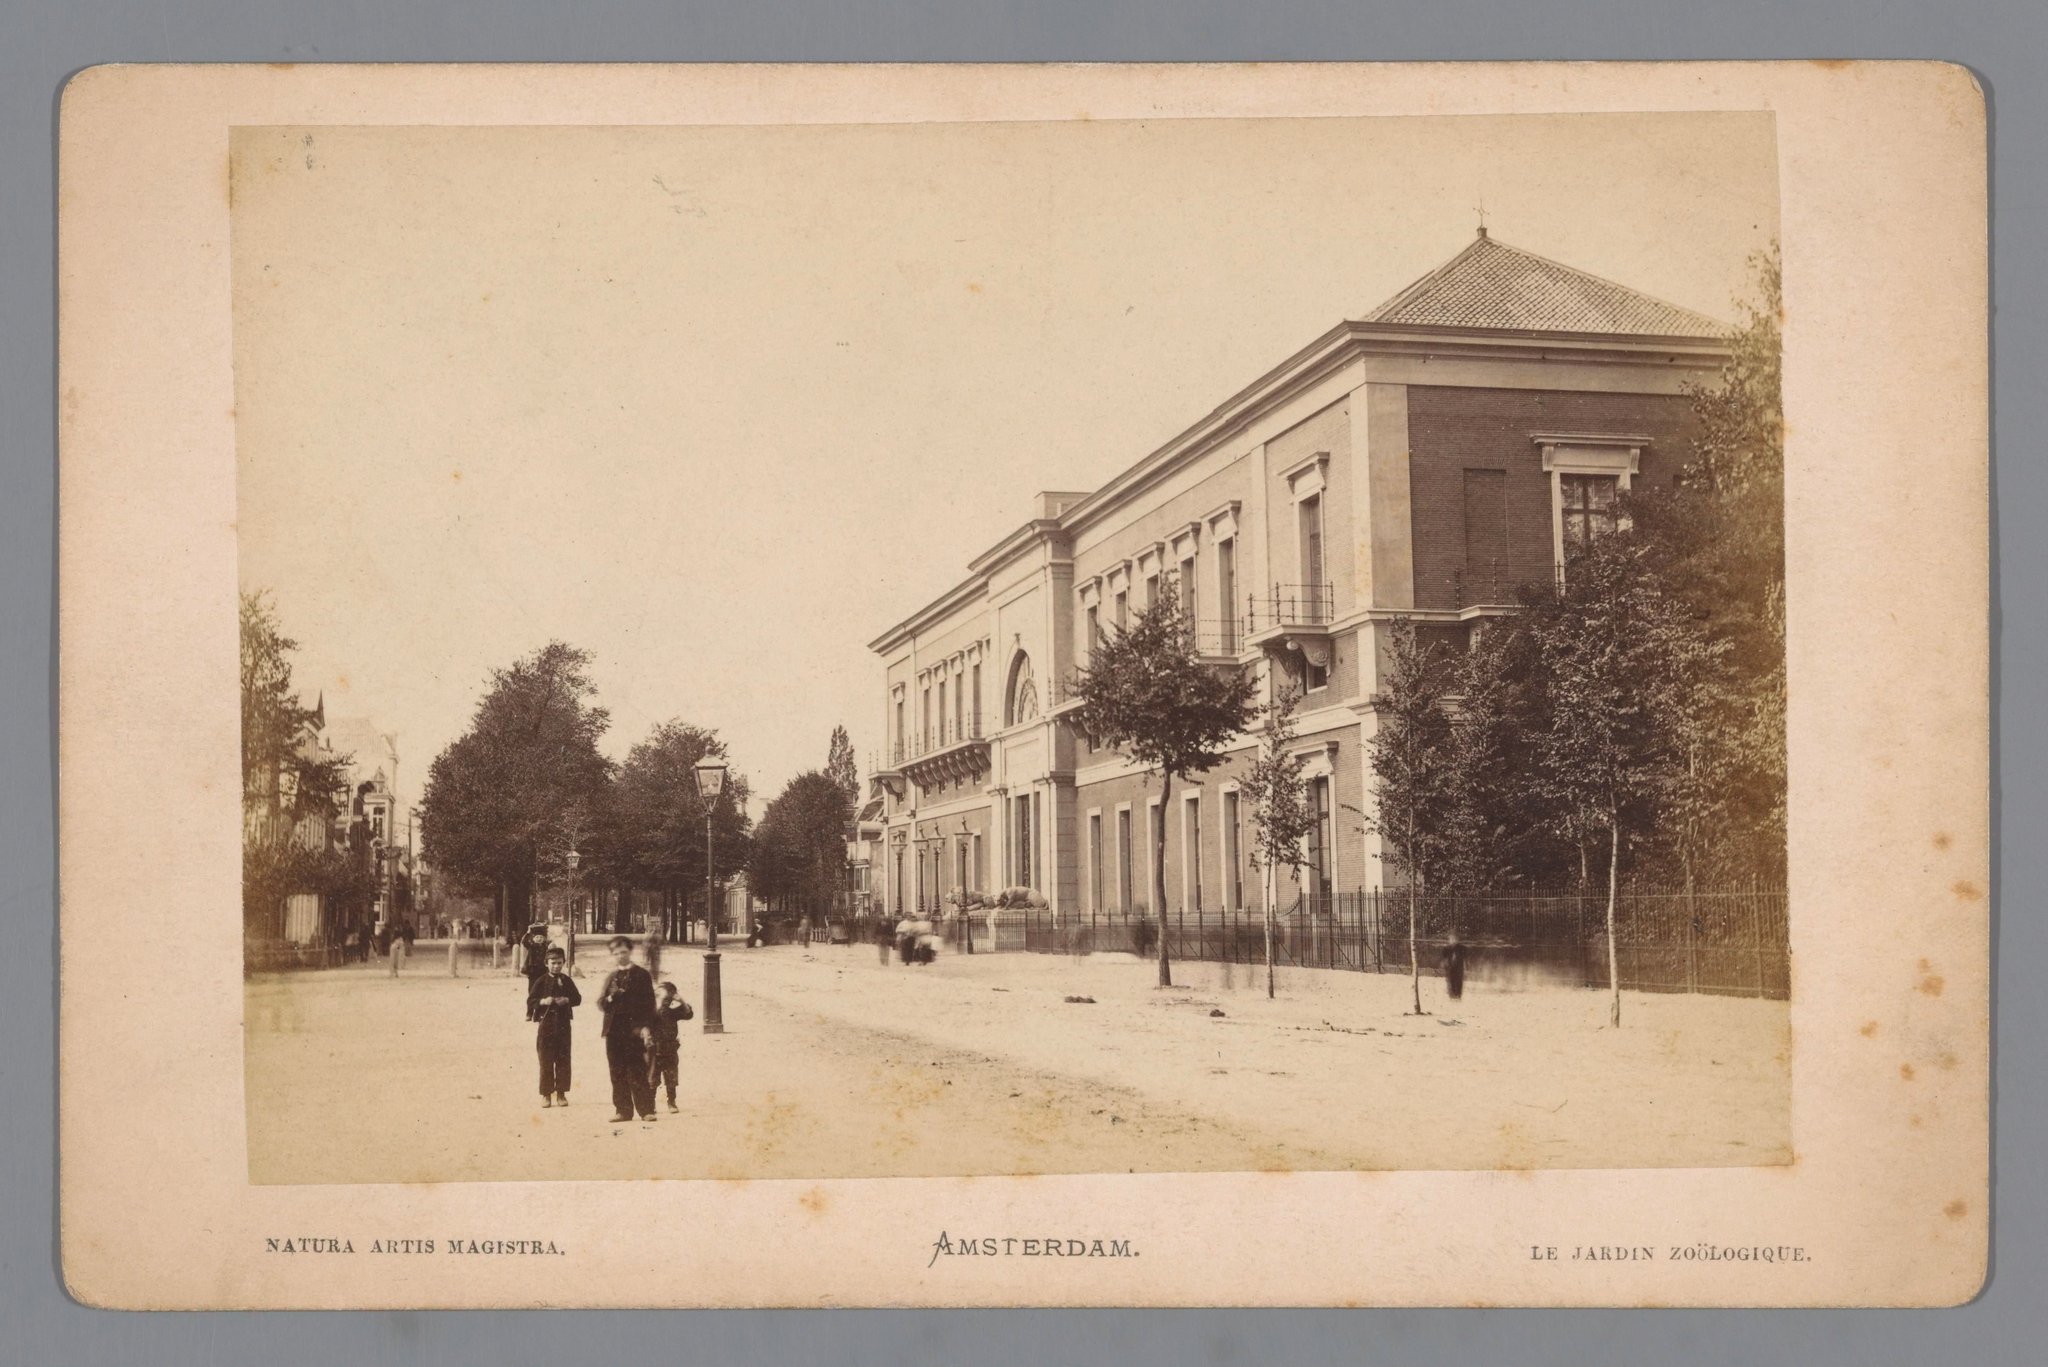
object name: cabinet photograph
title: Gezicht op het hoofdgebouw van Artis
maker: andries jager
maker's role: publisher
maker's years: 1825-1905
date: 1860-1890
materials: cardboard, photographic support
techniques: albumen print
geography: amsterdam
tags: permanent exhibition, museum, zoological garden, zoo, seen as place where non-domestic animals are kept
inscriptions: number: ‘17’